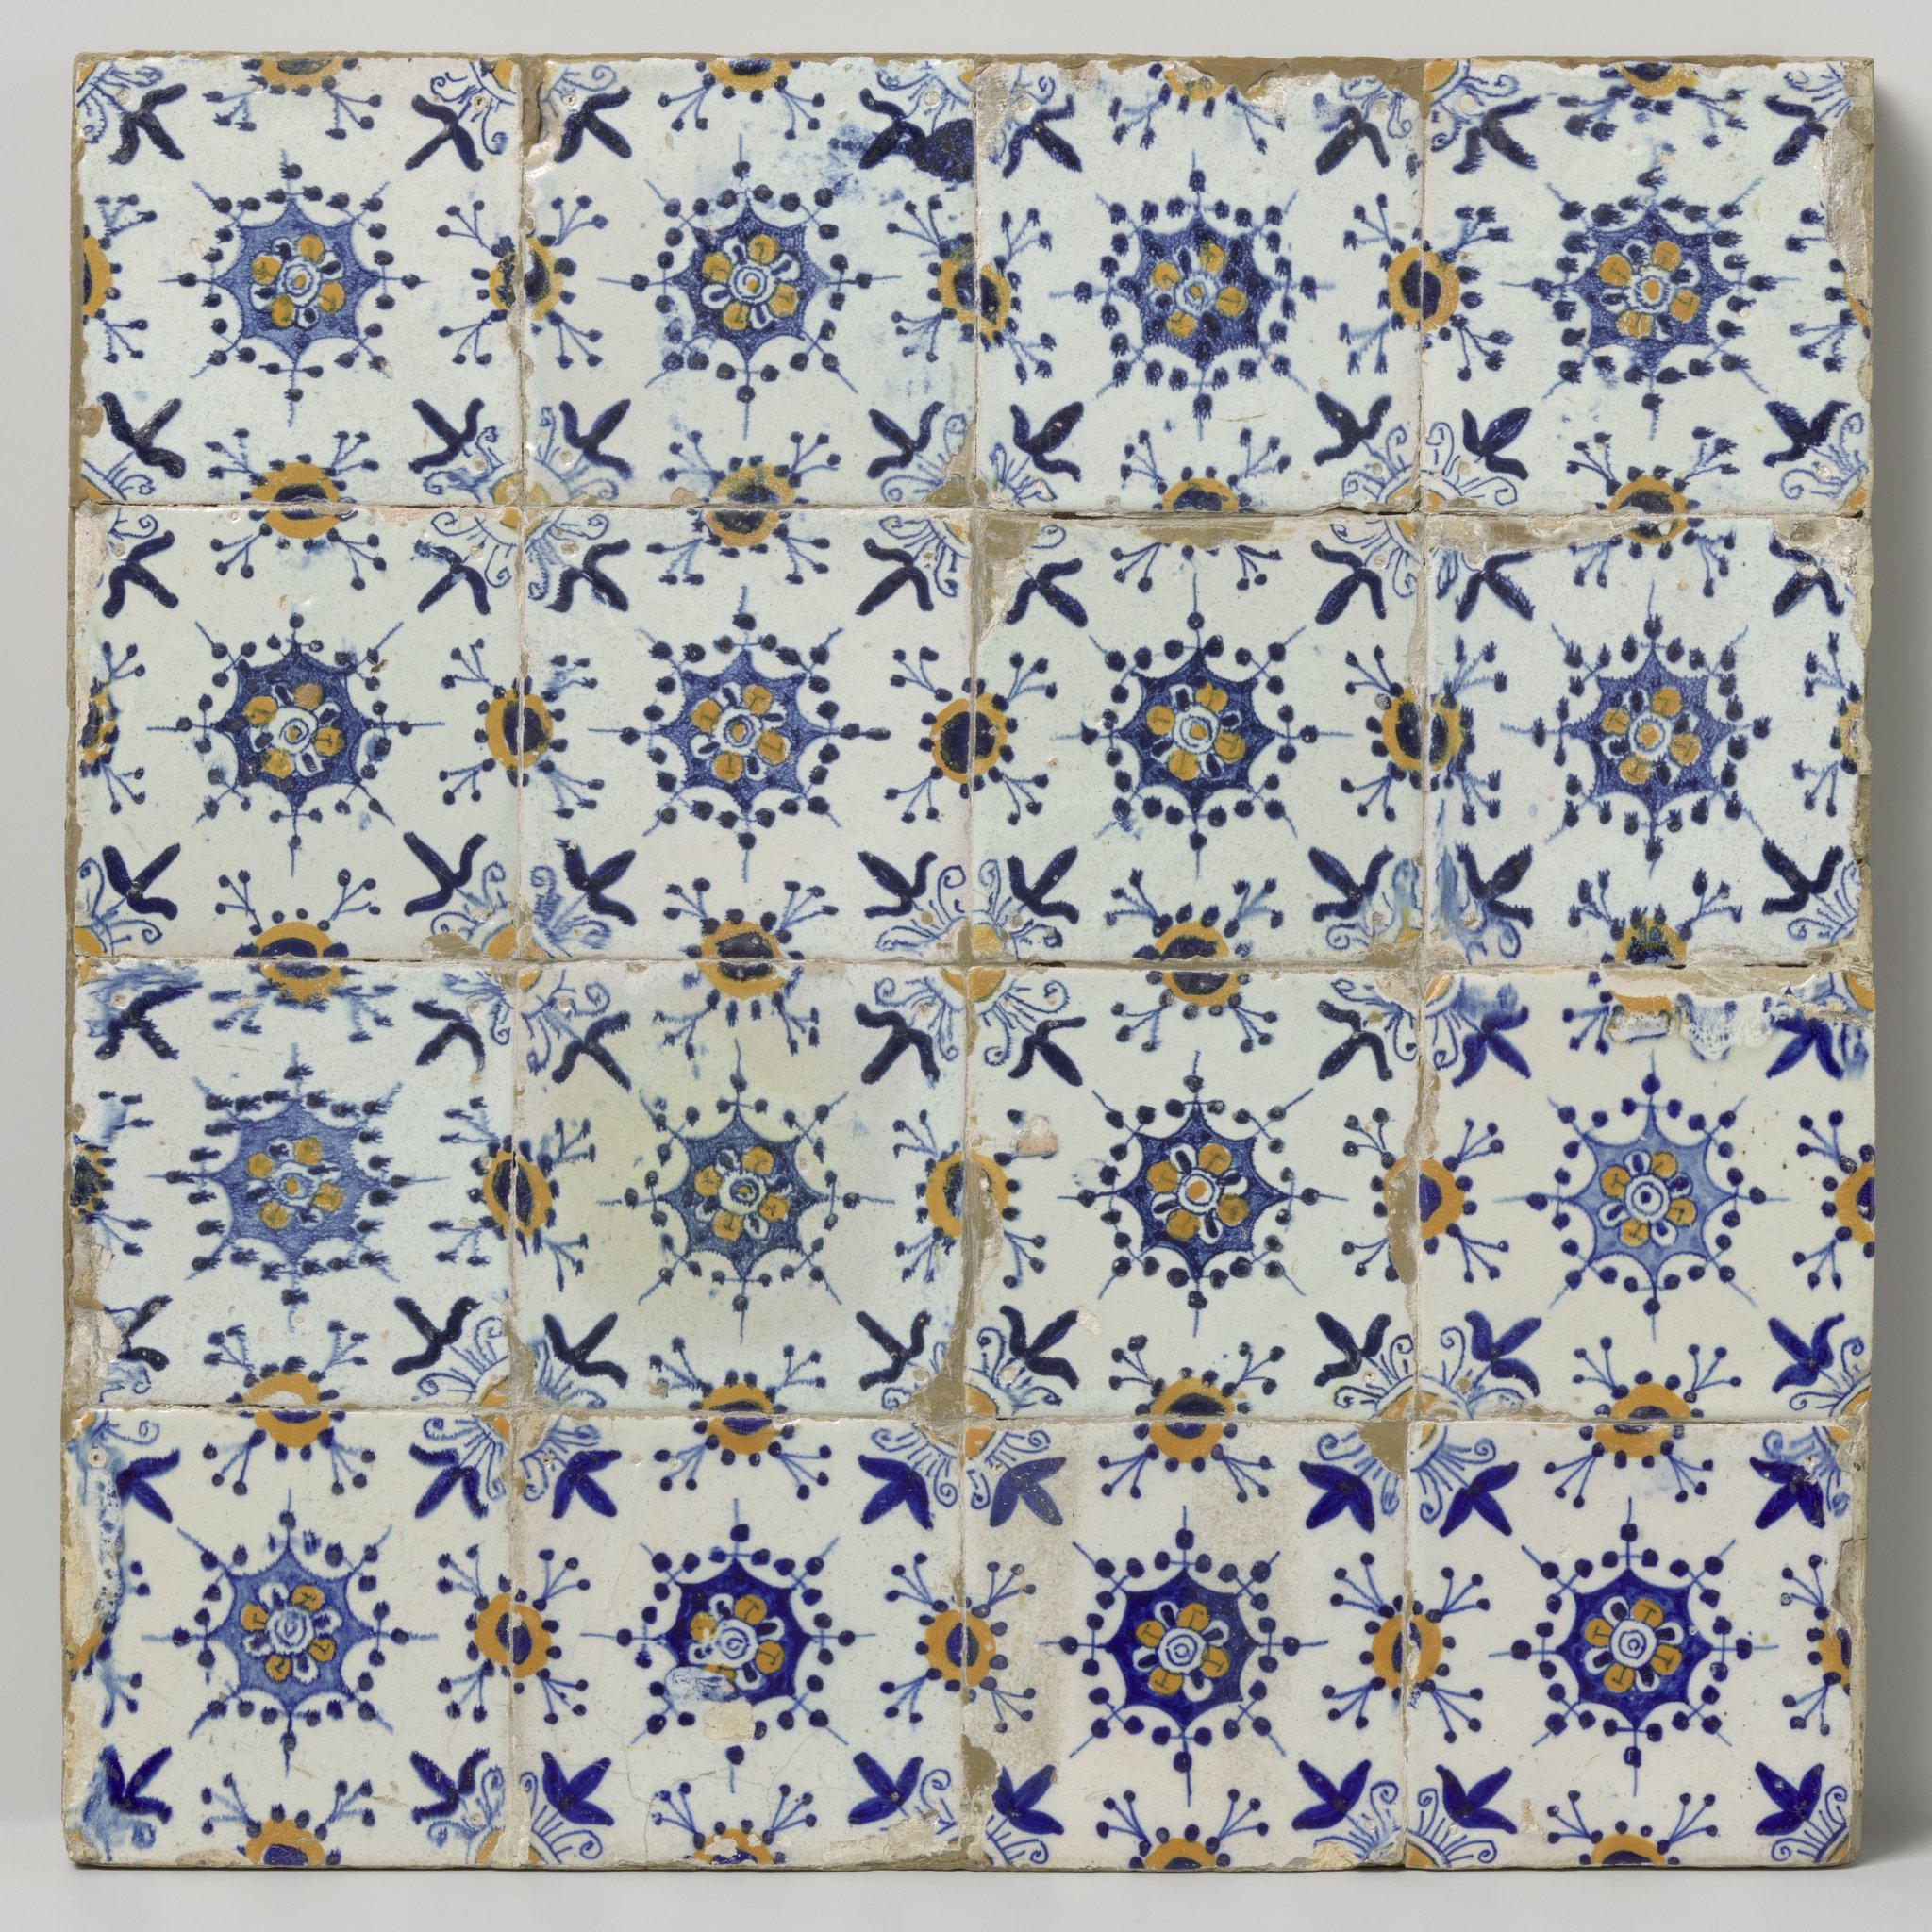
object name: tile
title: Veld van zestien tegels (4x4) elk met een veelkleurig patroon in blauw, geel en oranje van een rozet omgeven door drie stippen met in de hoeken een lelie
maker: Anonymous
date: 1640-1660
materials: earthenware, glaze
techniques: maiolica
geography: haarlem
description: Veld van zestien tegels (4 x 4) elk met een veelkleurige (blauw, geelen oranje) rozet omgeven door drie stippen met in de hoeken een lelie.